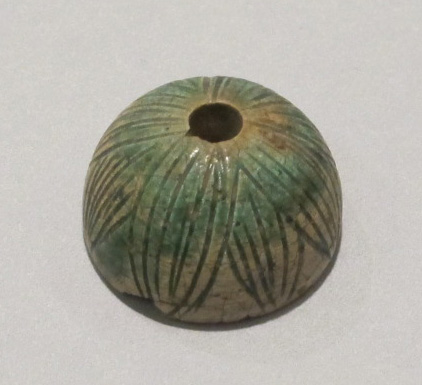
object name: ornament, leaf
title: Ornament, leaves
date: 1550-1295 BCE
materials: faience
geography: egypt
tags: leaves